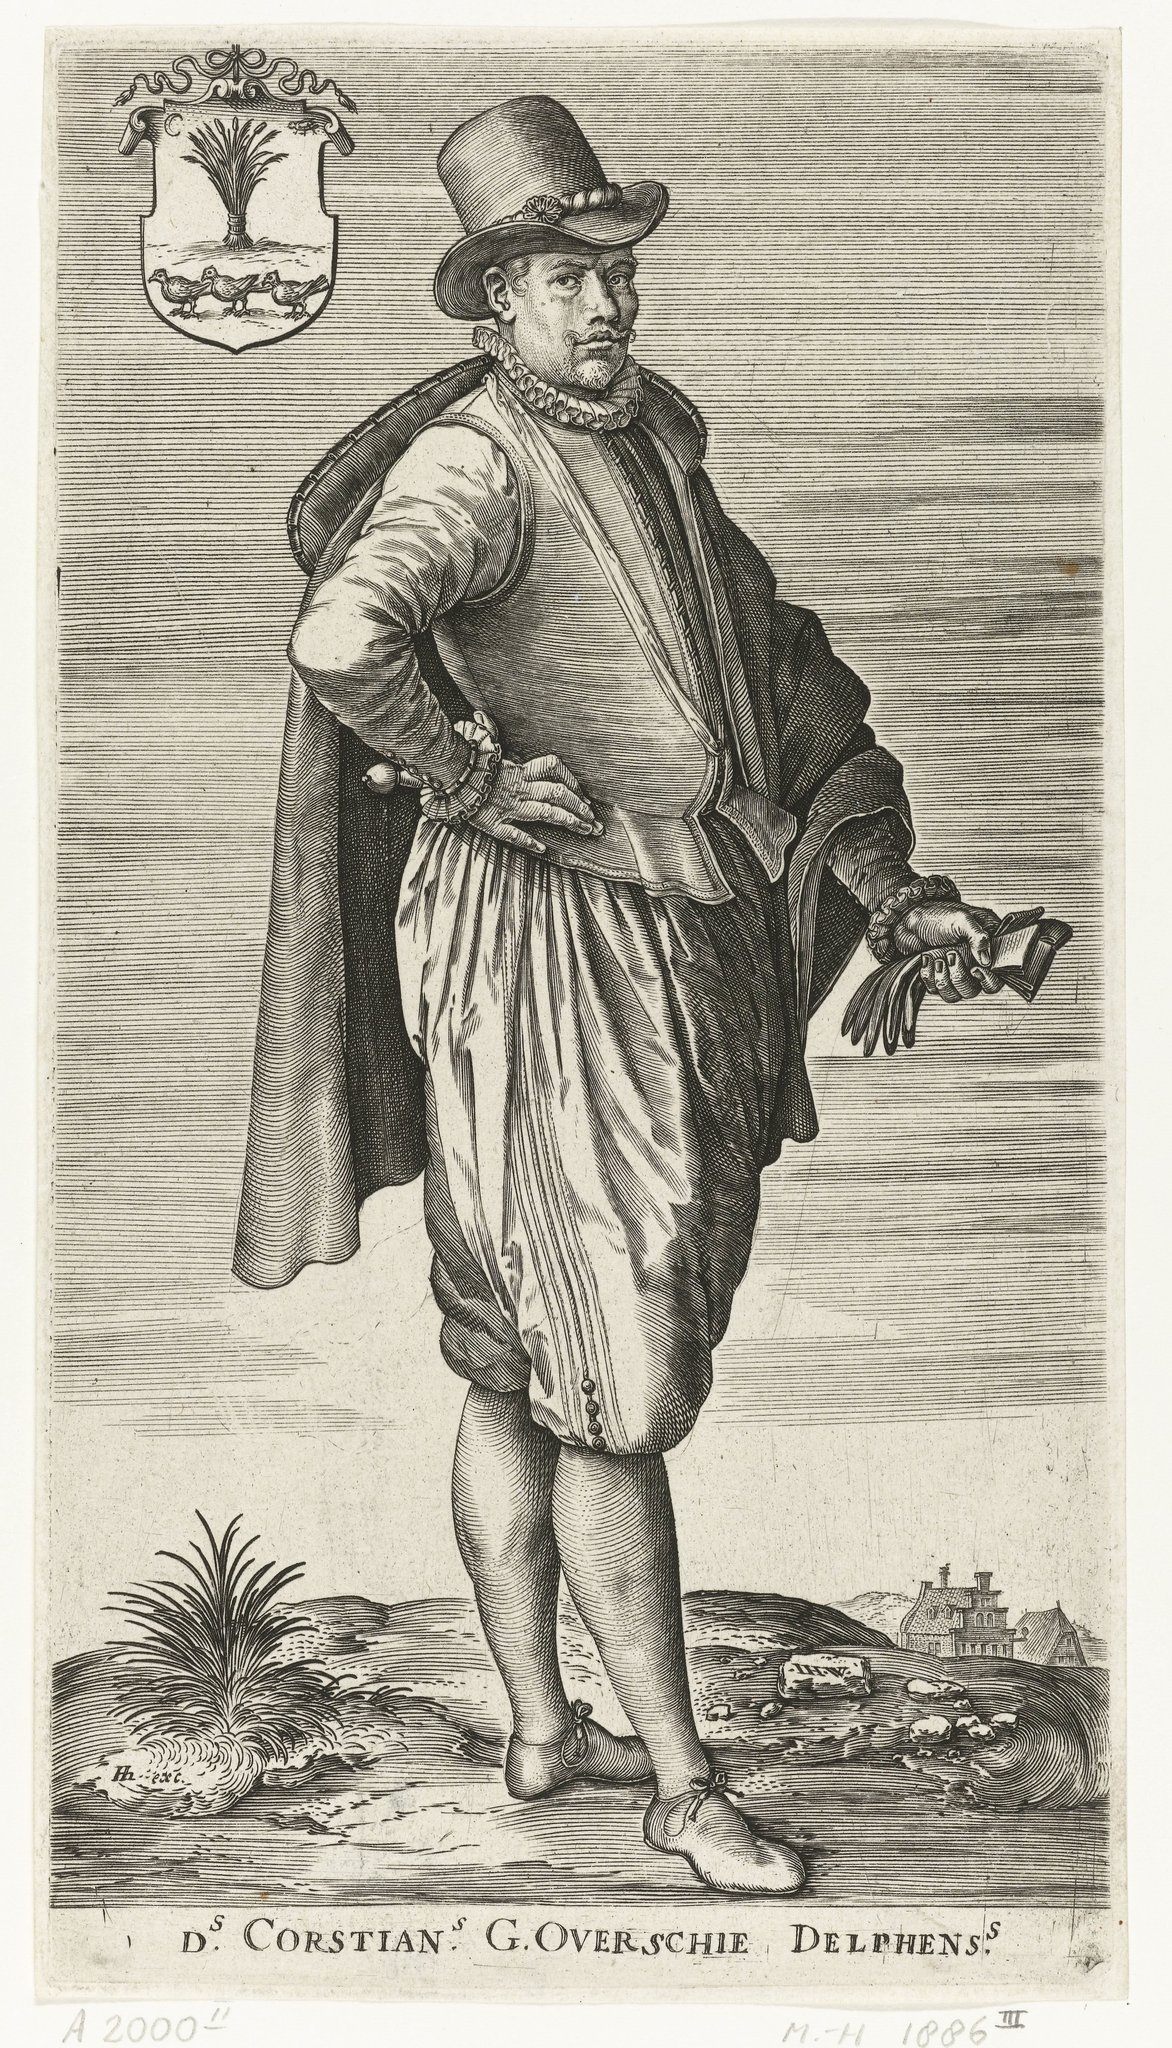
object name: print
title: Portret van de astroloog Corstianus G. Overschie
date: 1579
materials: paper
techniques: engraving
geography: the hague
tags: neck-gear ~ clothing (with name) (+ men's clothes), cape (+ men's clothes), head-gear: hat (+ men's clothes), shoes, sandals (+ men's clothes), clothes, costume (+ men's clothes), trousers, breeches, etc. (breeches) (+ men's clothes), clothing for the upper part of the body (doublet) (+ men's clothes), gloves, mittens, etc. (+ men's clothes), stockings, socks (+ men's clothes), sleeves (+ men's clothes), armorial bearing, heraldry, netherlands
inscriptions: collector's mark: Lugt 240, number: ‘22. - 56.’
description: Portret van Corstianus G. Overschie, ten voeten uit, in de buitenlucht, een paar handschoenen in de hand. Linksboven zijn wapenschild.